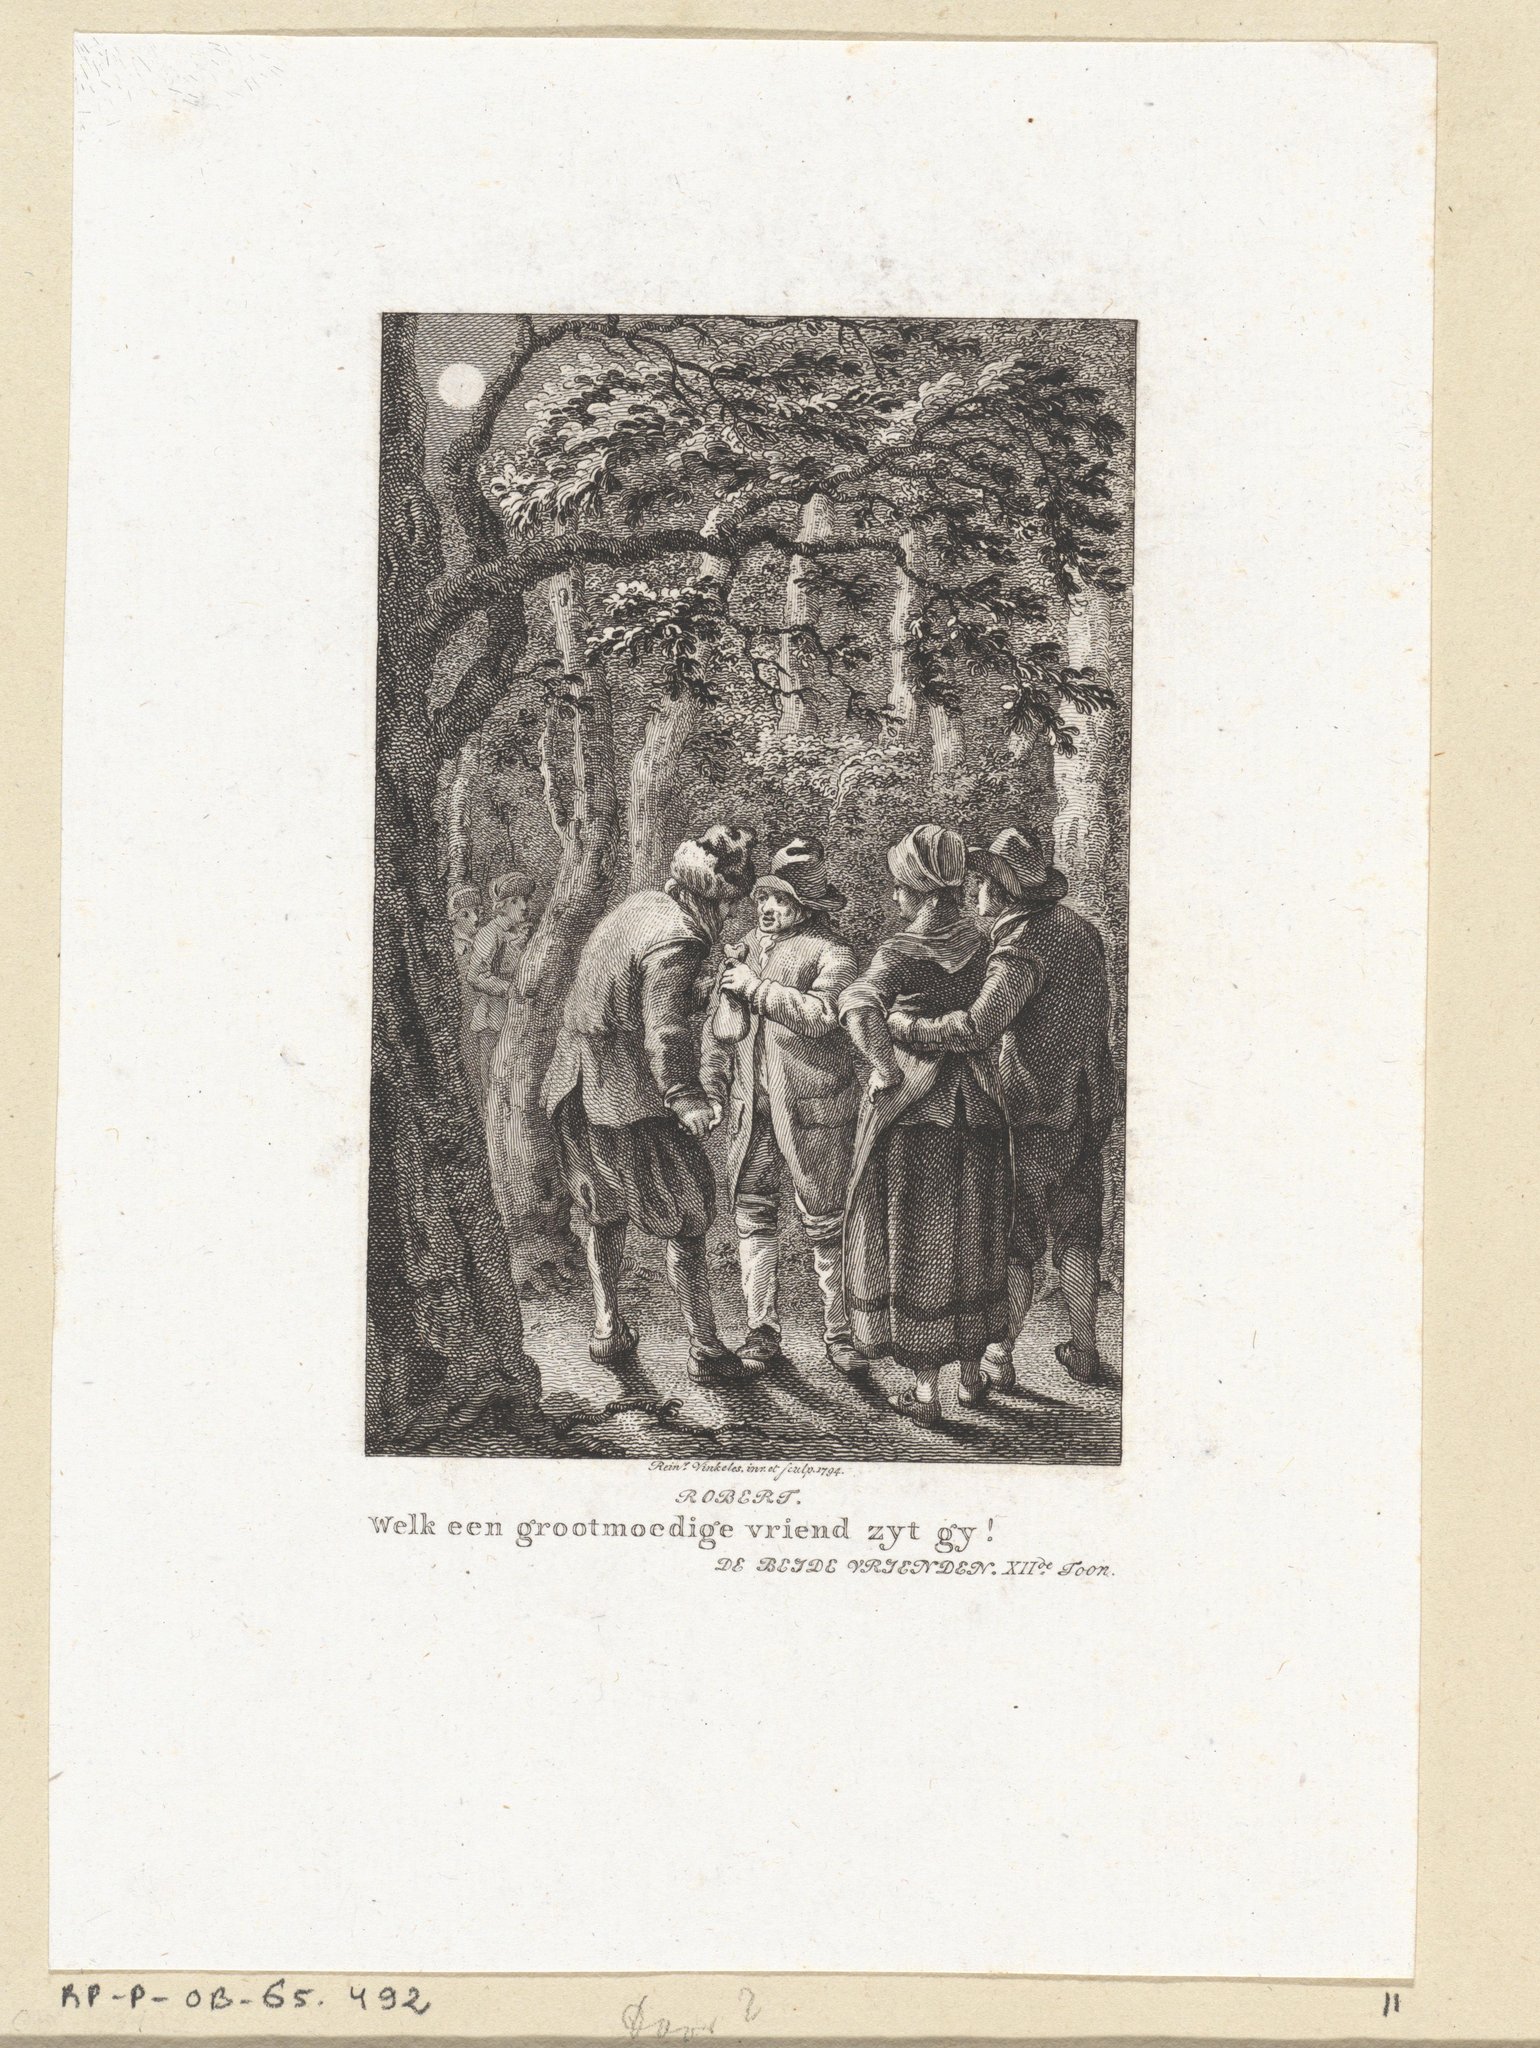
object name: print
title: Nachtgezicht met figuren met een geldzak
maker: reinier vinkeles (i)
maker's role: draughtsman, print maker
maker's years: 1741-1816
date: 1794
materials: paper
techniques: engraving, etching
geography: amsterdam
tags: purse, money-bag, forest, wood, bringing gifts; exchanging gifts, night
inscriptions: collector's mark: Lugt 240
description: In een bos bij nacht wisselen twee mannen een geldzak en iets anders met elkaar uit, onder het toeziend oog van een paar. Op de achtergrond staan twee mannen naar het tafereel te kijken, verborgen achter het geboomte.